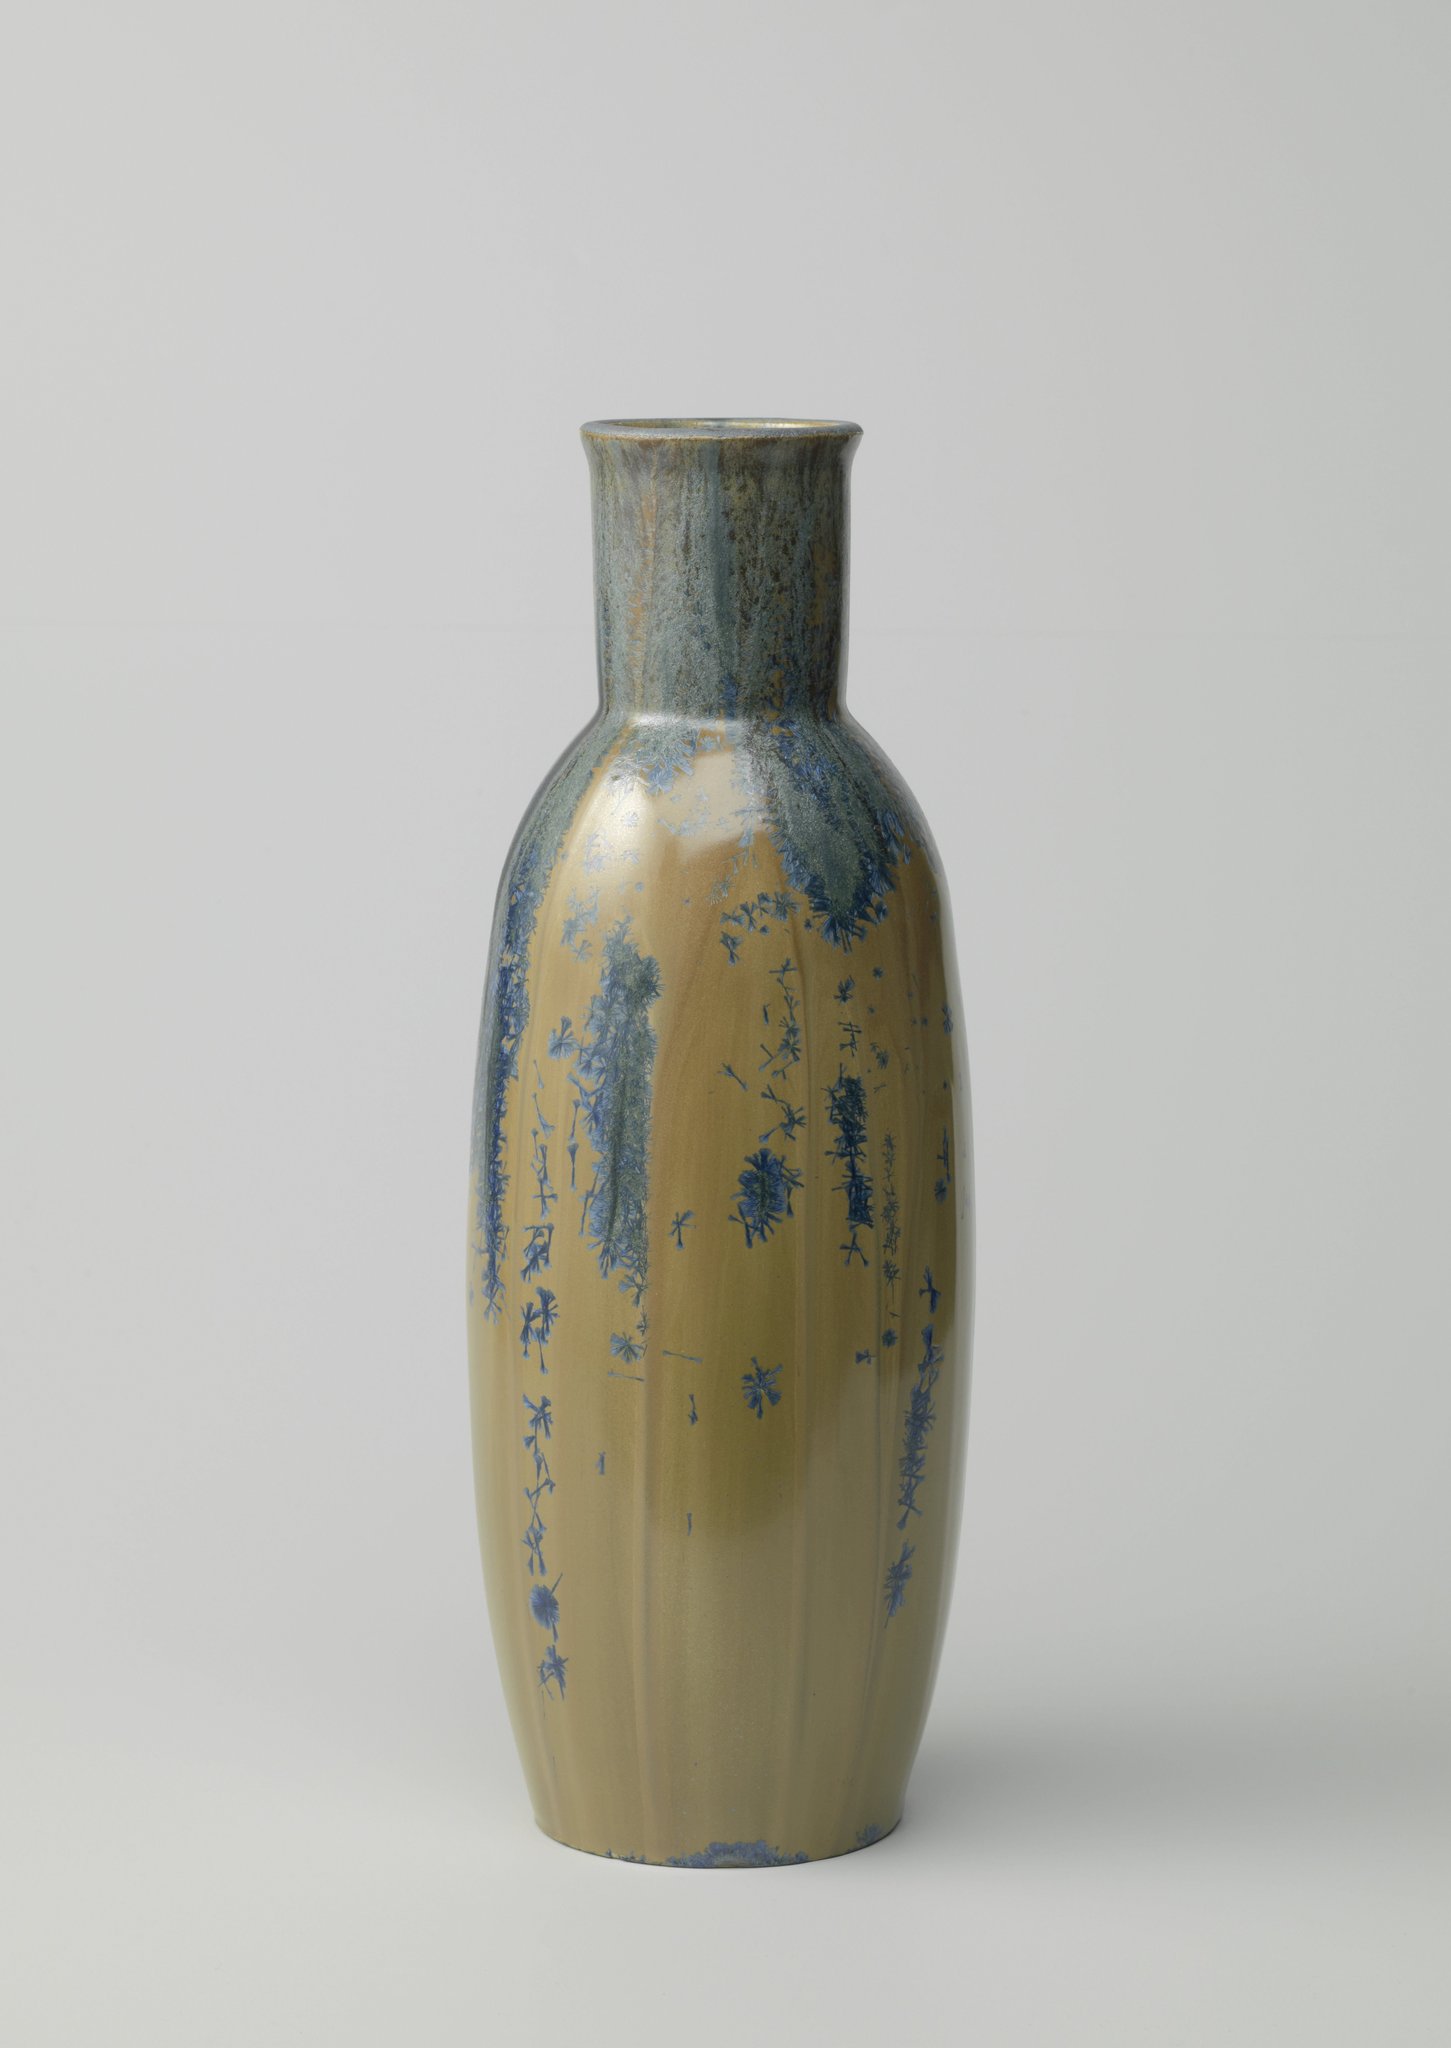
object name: vase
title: Vase with a Crystalline Glaze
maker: pierre adrien dalpayrat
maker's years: 1844-1910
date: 1890-1893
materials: stoneware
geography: bourg-la-reine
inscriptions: mark: ‘ingestempeld 1008 Dalpayrat en 31 in rood.’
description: Vaas van steengoed, versierd met blauwe kristalglazuur op lichtbruine fond. Slanke, iets gebogen cilindervorm met inspringende cilindervormige hals. Gemerkt met: ingestempeld 1008 Dalpayrat en 31 in rood.